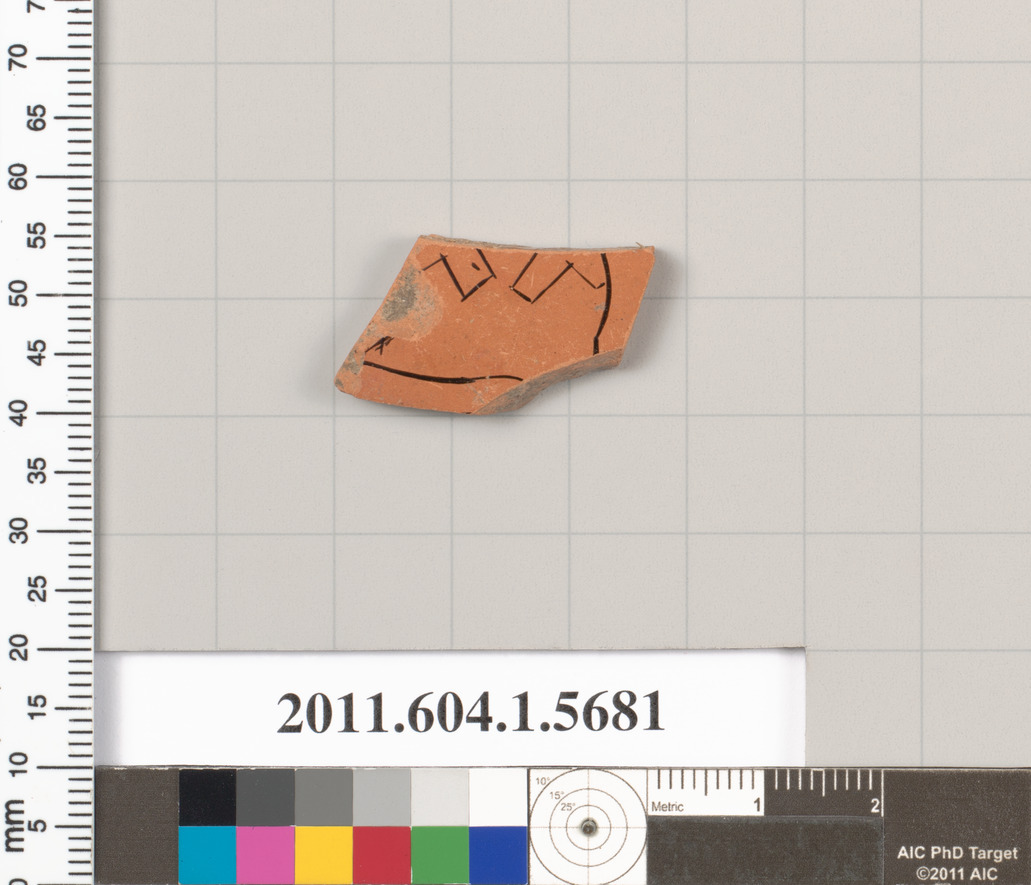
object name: kylix fragment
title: Terracotta fragment of a kylix (drinking cup)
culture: greek, attic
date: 500-480 BCE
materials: terracotta